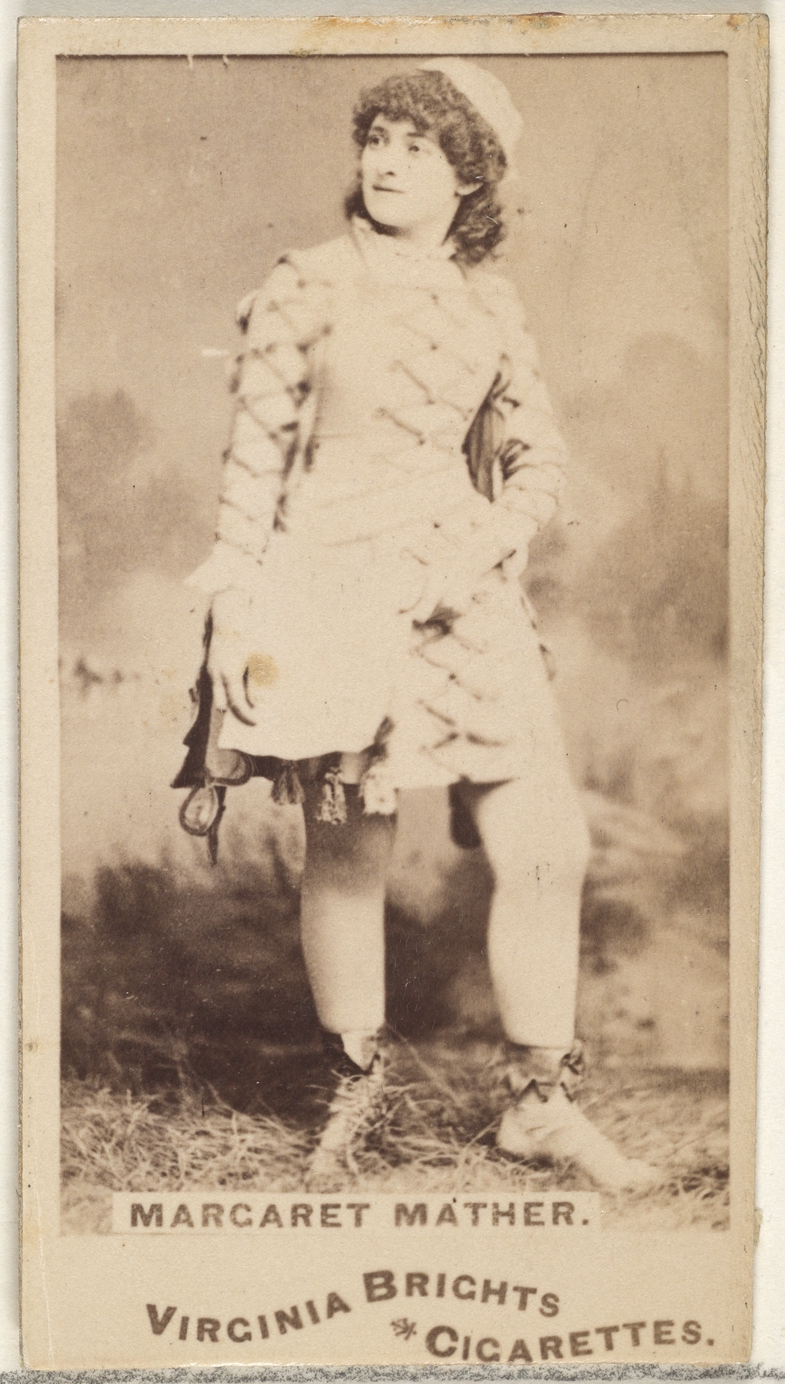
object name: photograph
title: Margaret Mather, from the Actors and Actresses series (N45, Type 1) for Virginia Brights Cigarettes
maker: allen & ginter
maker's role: publisher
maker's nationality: american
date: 1888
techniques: albumen silver print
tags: portraits,women,actresses